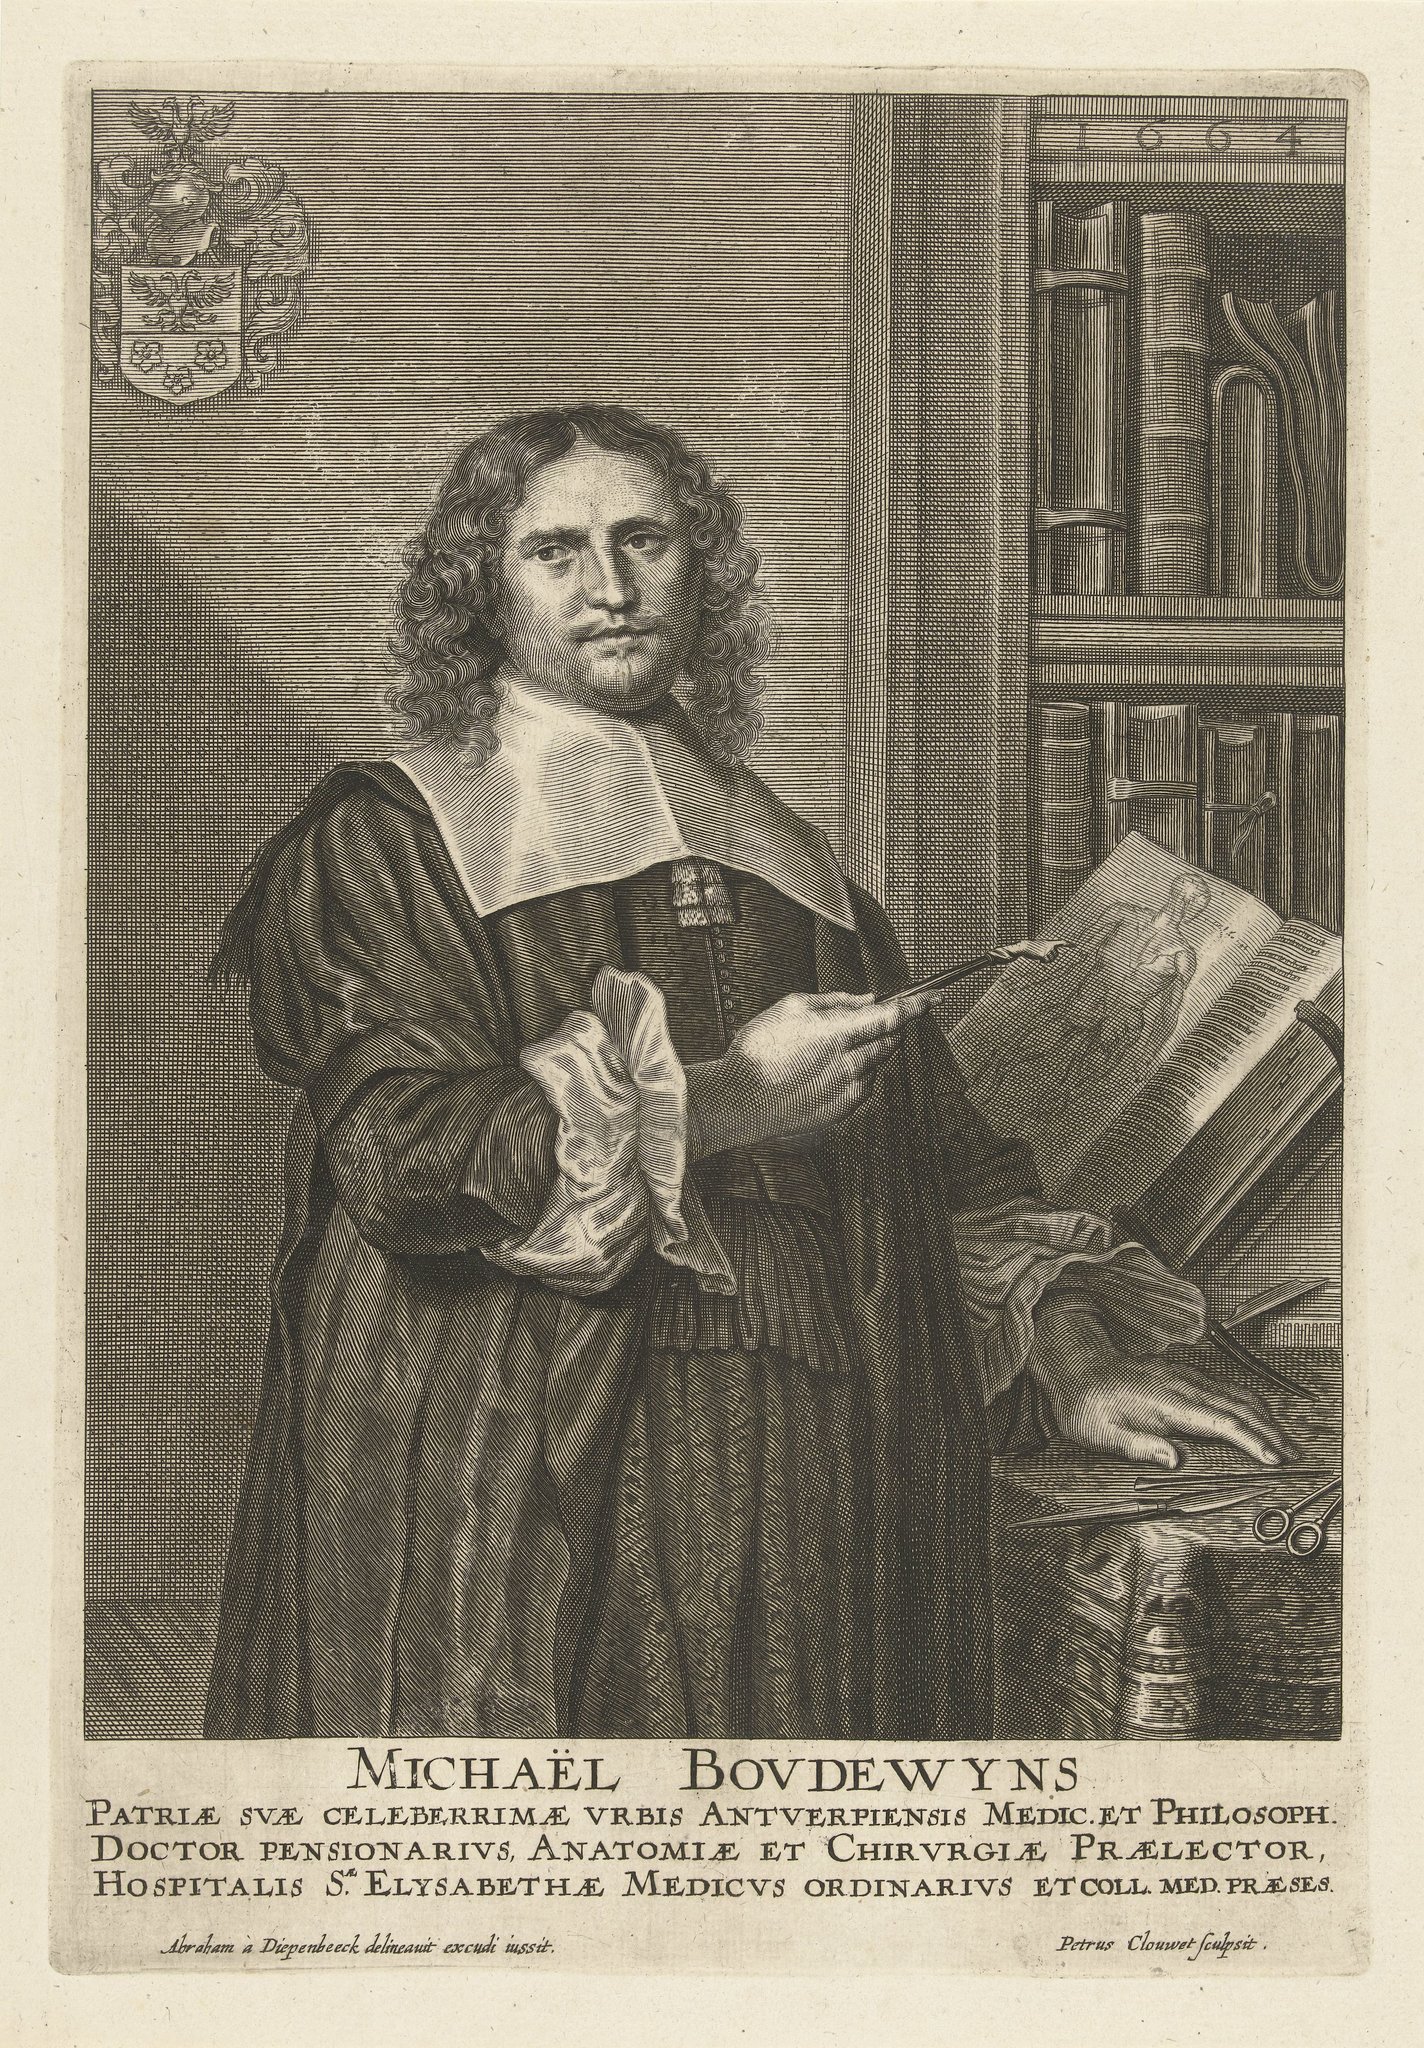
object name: print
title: Portret van Michiel Boudewijns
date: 1639-1670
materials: paper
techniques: engraving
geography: antwerp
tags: antwerp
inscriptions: collector's mark: Lugt 2228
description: Portret van de Antwerpse chirurgijn en geneesheer Michiel Boudewijns in zijn studeerkamer. Hij staat voor zijn bureau en bestudeert een boek over anatomie. De prent heeft een Latijns onderschrift.